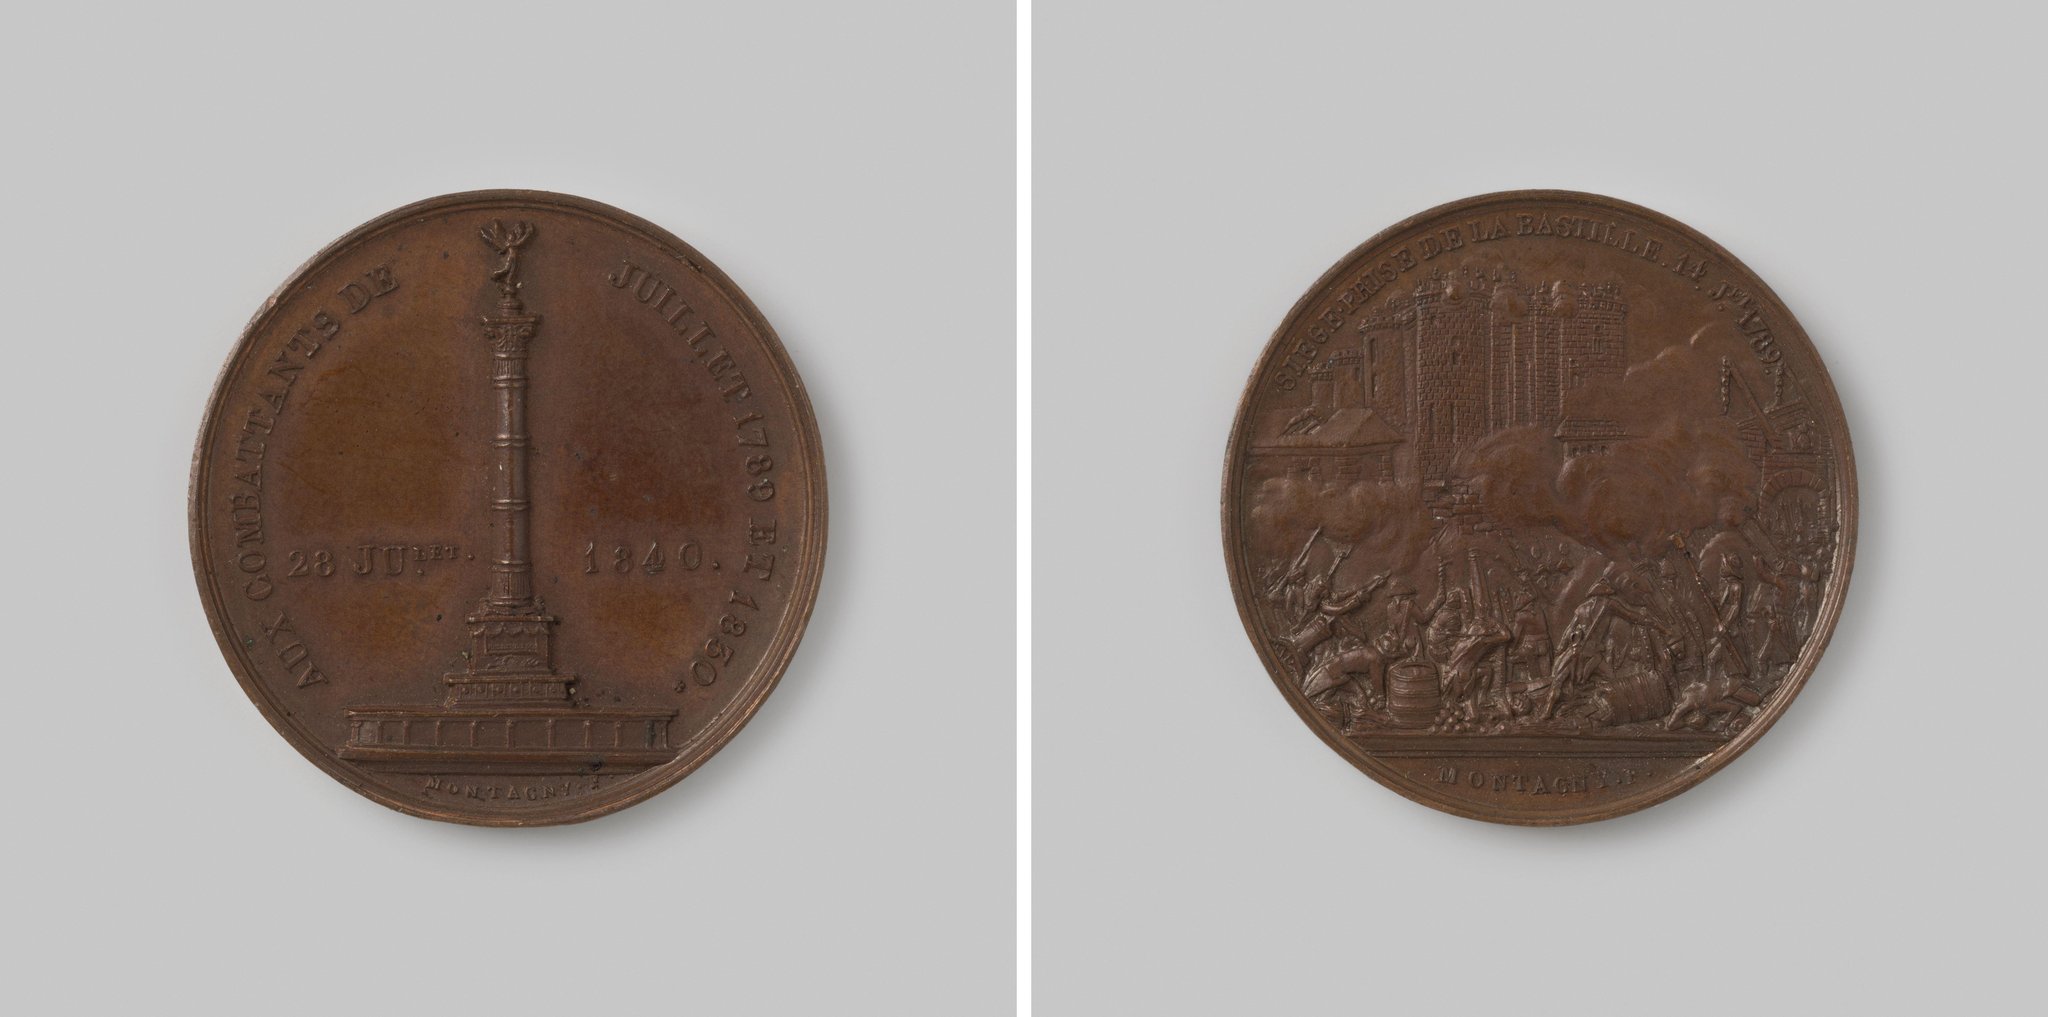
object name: history medal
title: Oprichting van de Juli-zuil te Parijs 1840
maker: montagny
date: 1840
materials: bronze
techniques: striking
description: Bronzen penning, op de voorzijde de bestorming van de Bastille met bovenaan omschrift, op de keerzijde de Juli-zuil met bijschrift en omschrift.